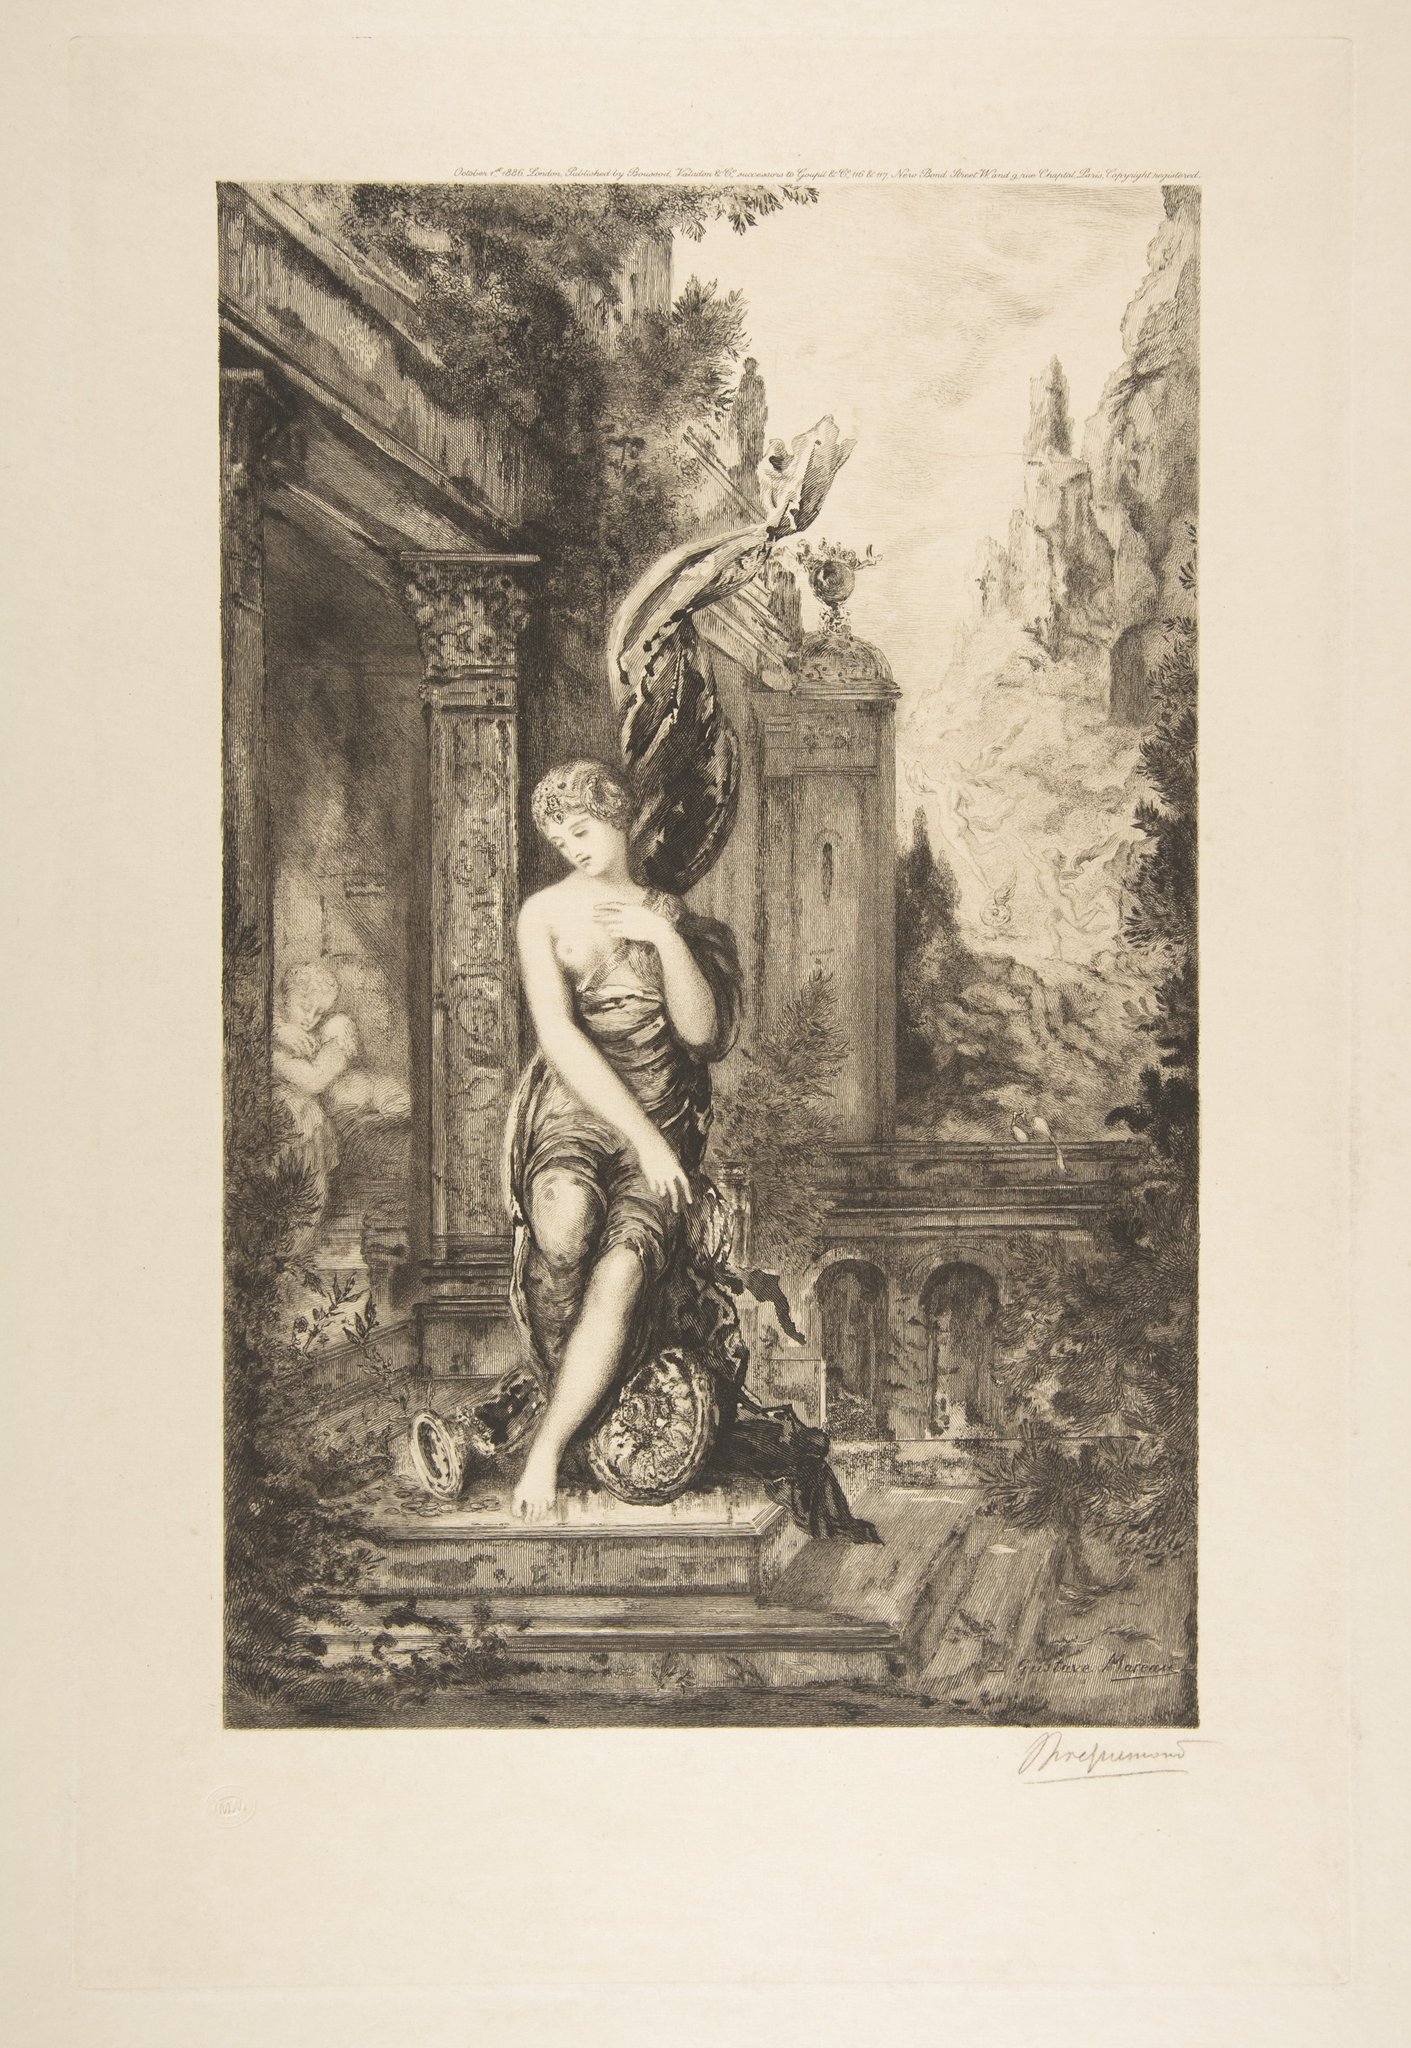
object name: print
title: L'Homme qui court après la Fortune et celui qui l'attend dans son lit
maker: félix bracquemond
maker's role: artist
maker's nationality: french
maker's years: 1833-1914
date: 1886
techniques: etching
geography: england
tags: women